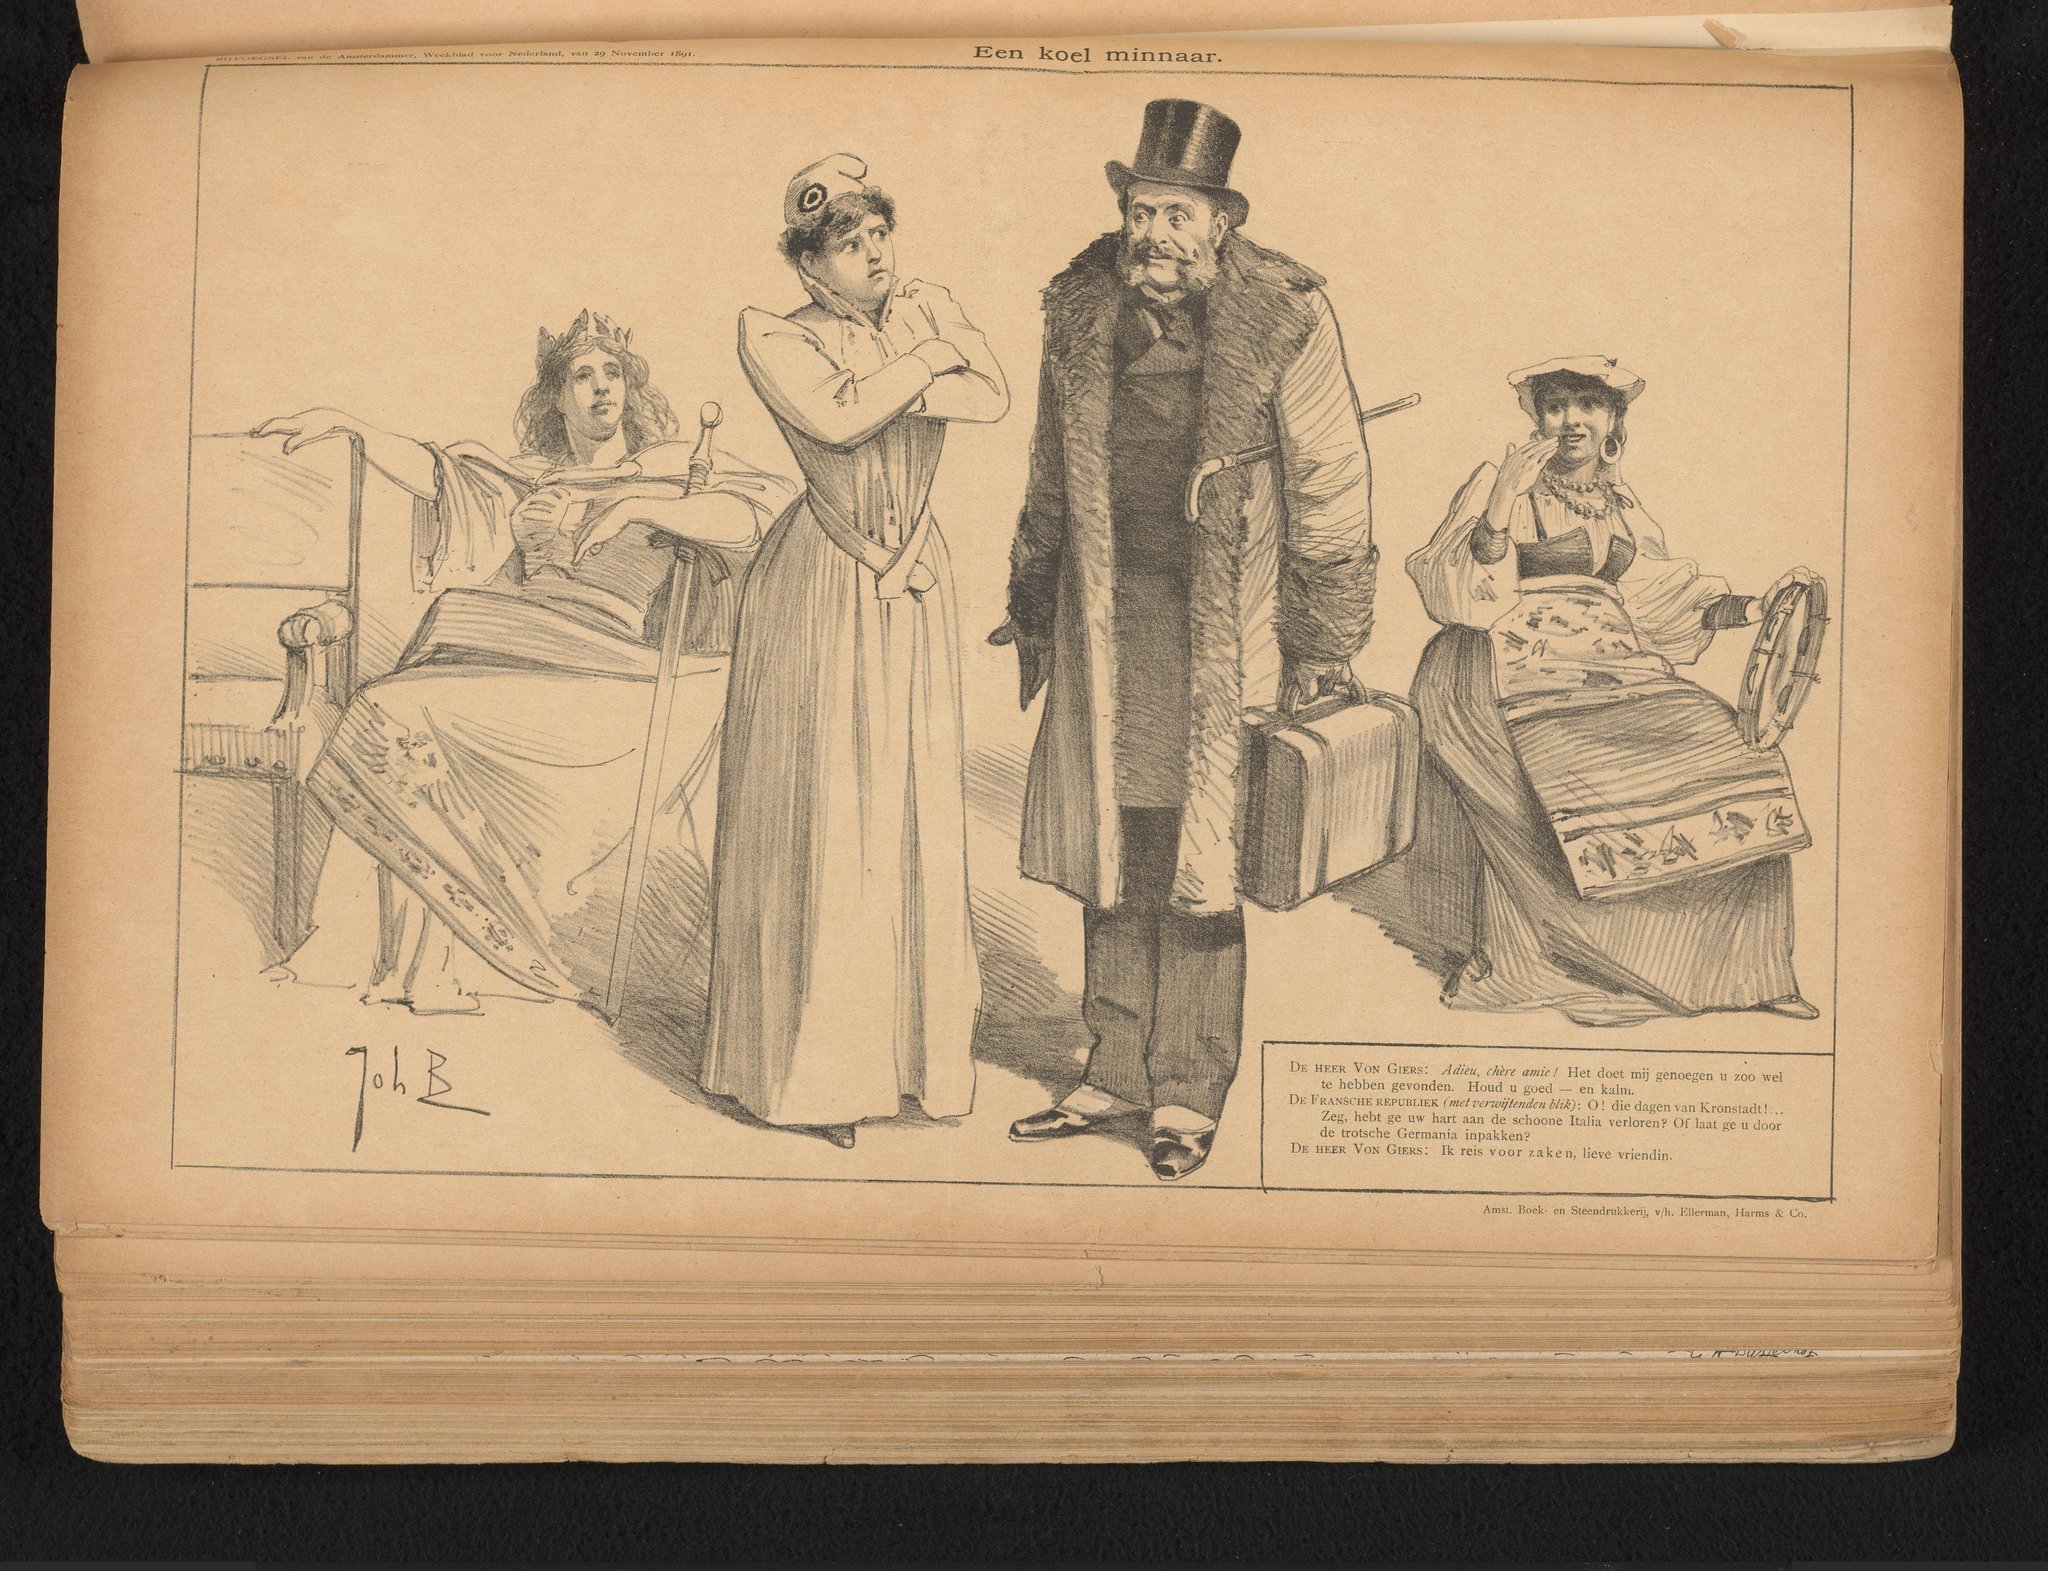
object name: cartoon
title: Een koel minnaar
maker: johan braakensiek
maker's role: draughtsman, print maker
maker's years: 1858-1940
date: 1891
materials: paper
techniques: lithograph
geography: amsterdam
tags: diplomacy, diplomat, personifications of countries, nations, states, districts, etc. (+ nation; national), political caricatures and satires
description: Frankrijk verwijt de Russische minister van Buitenlandse Zaken Nikolay Girs (Nicolaas de Giers) zich te hebben laten inpakken door Duistland en Italië.